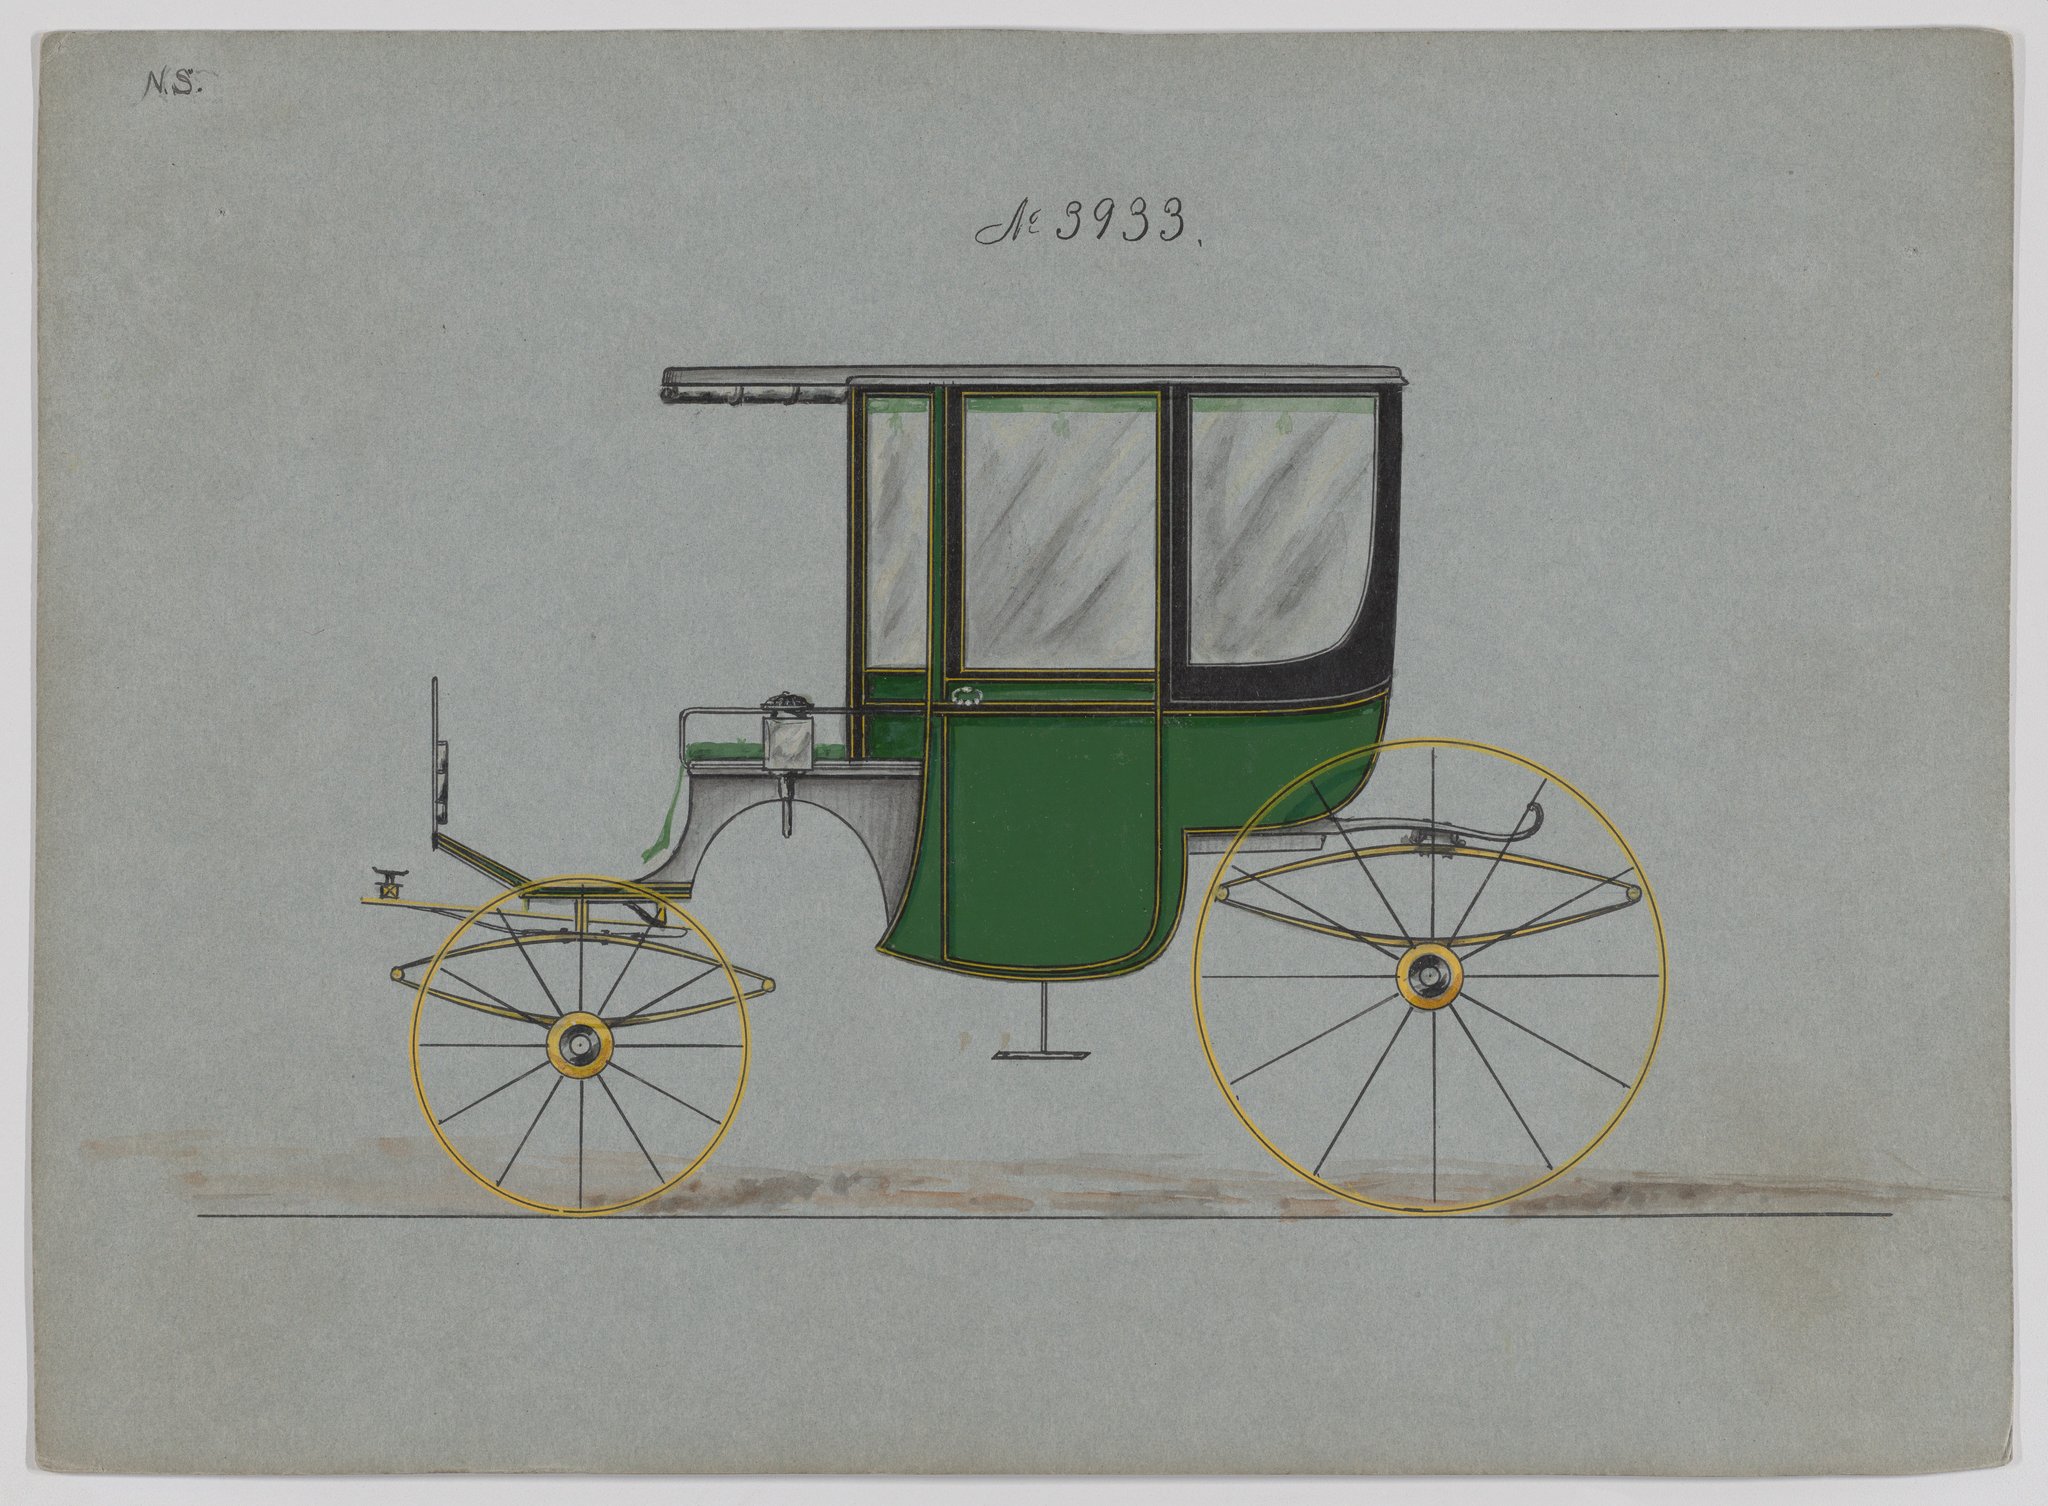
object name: drawing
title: Design for 4 seat Rockaway, no. 3933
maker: brewster & co.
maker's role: manufacturer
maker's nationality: american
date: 1884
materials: gouache, ink, watercolor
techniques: pen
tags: carriages